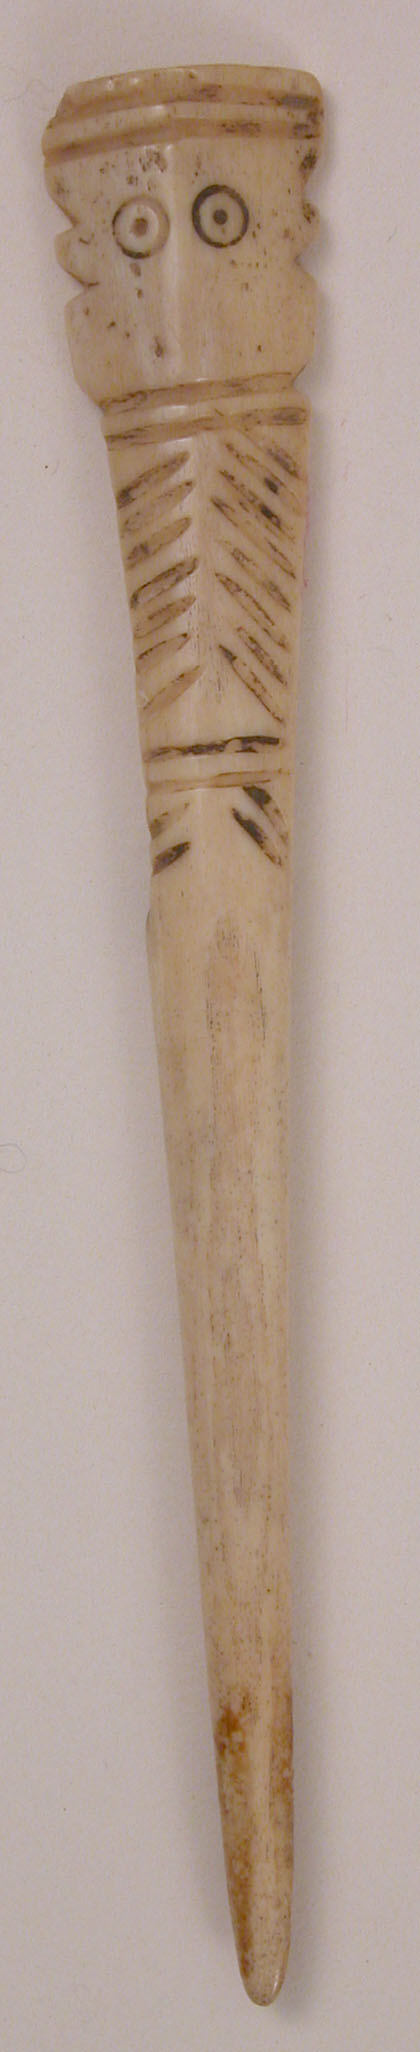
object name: pin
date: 901-1500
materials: bone, paint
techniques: incising, inlay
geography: egypt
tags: pins